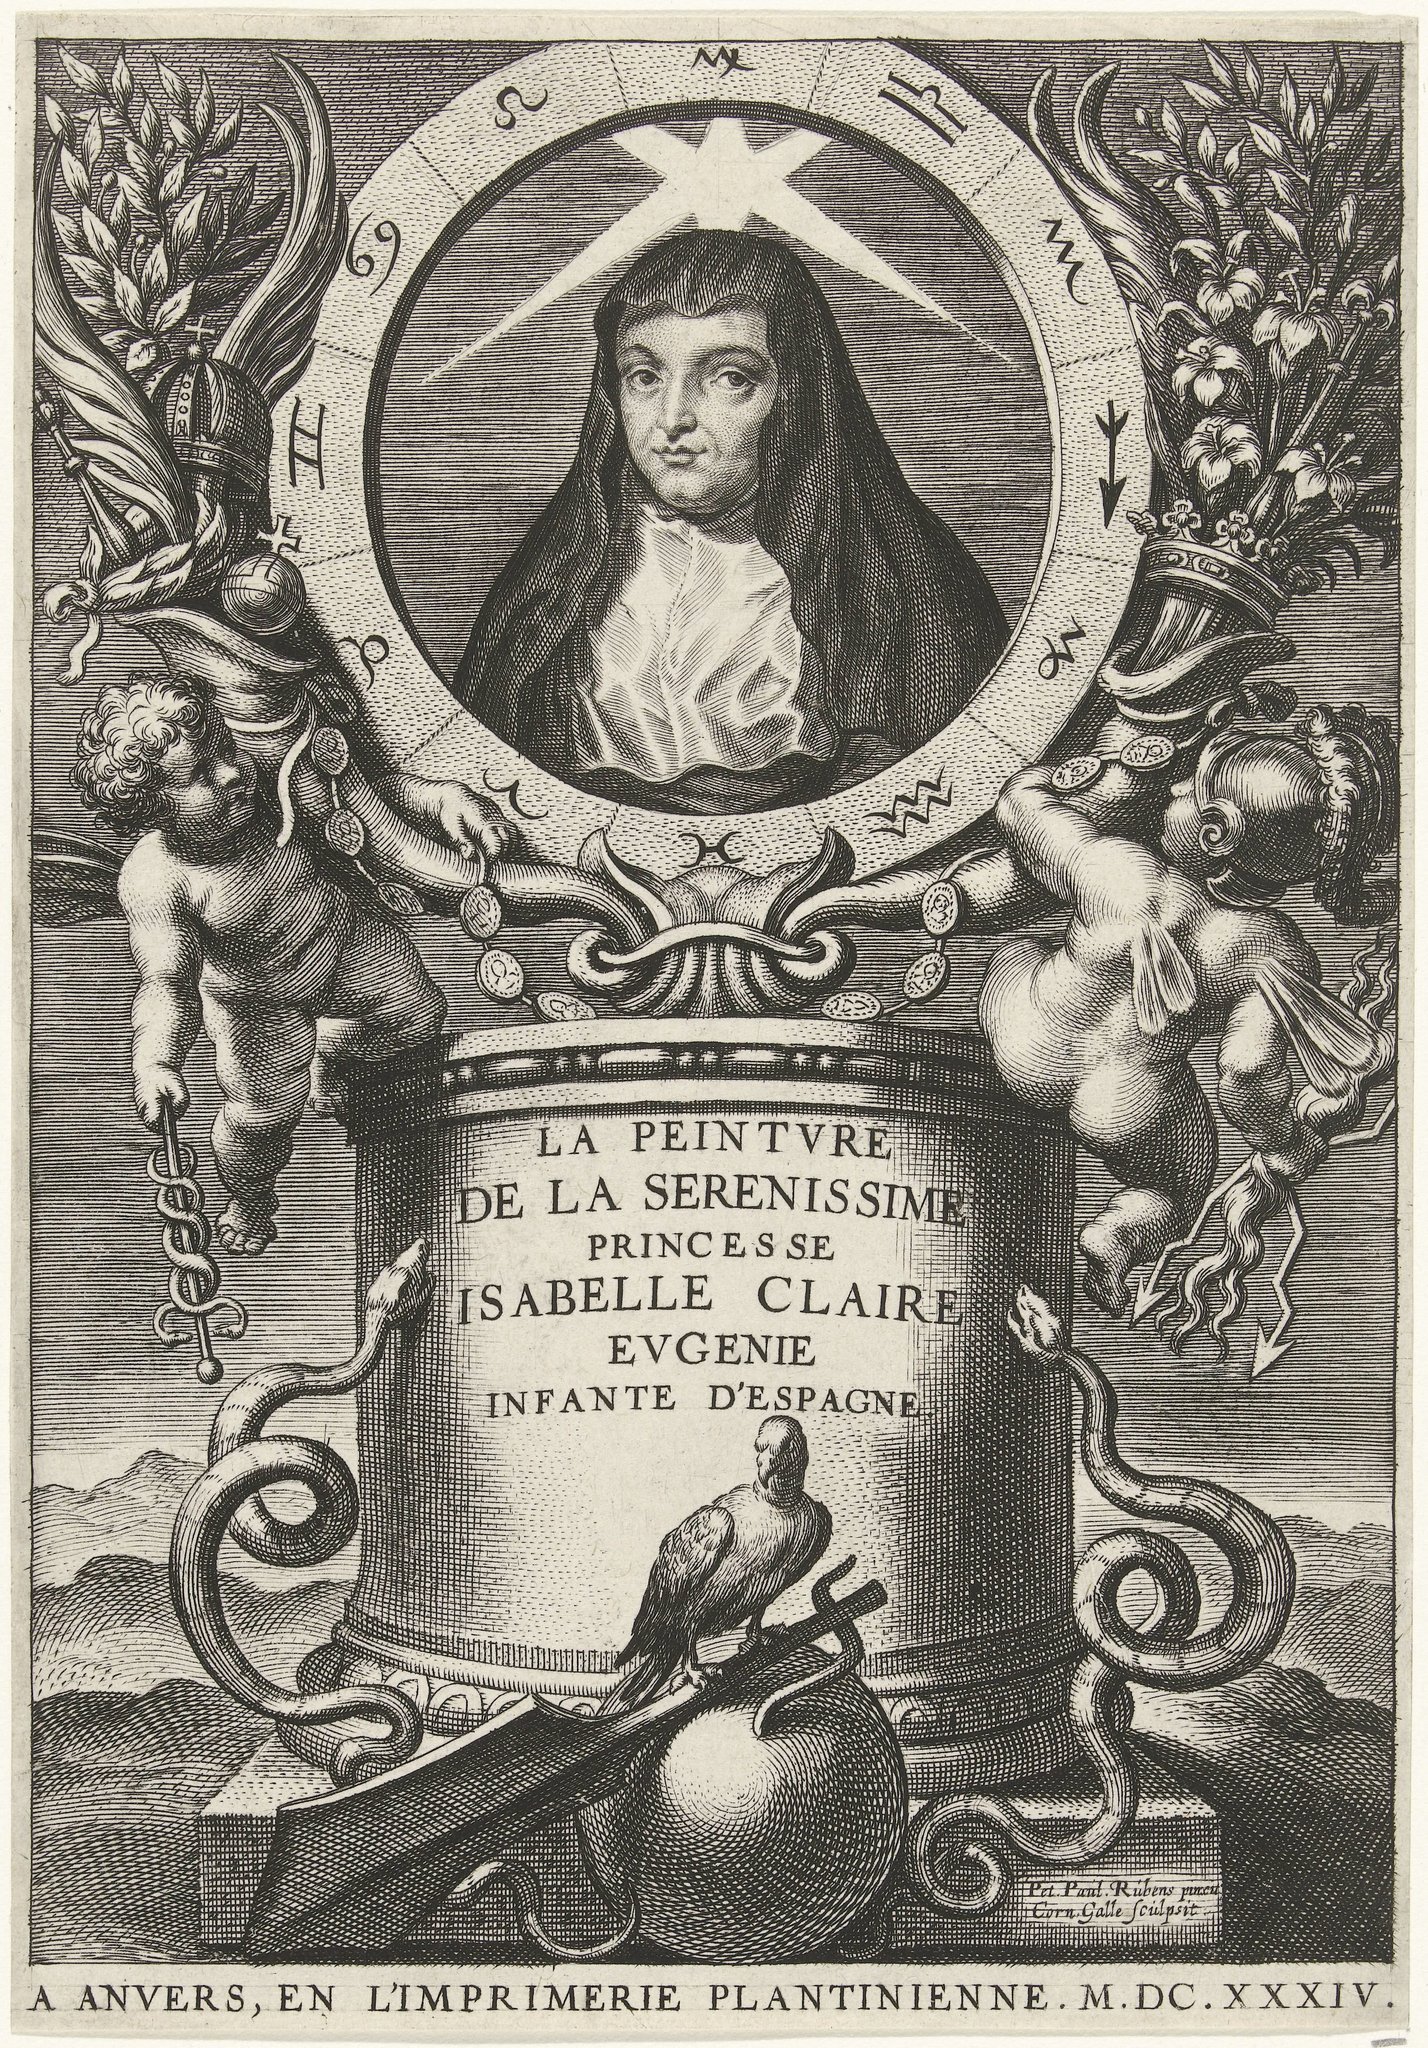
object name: print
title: Portret van Isabella Clara Eugenia, infante van Spanje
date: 1634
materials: paper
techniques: engraving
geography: southern netherlands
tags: infante van spanje isabella clara eugenia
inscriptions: collector's mark: Lugt 240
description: Portret van Isabella Clara Eugenia, infante van Spanje, als Clarissenzuster. In een ornamentele omlijsting met twee putti met caduceus en bliksemschicht en twee slangen en een adelaar op een wereldbol.